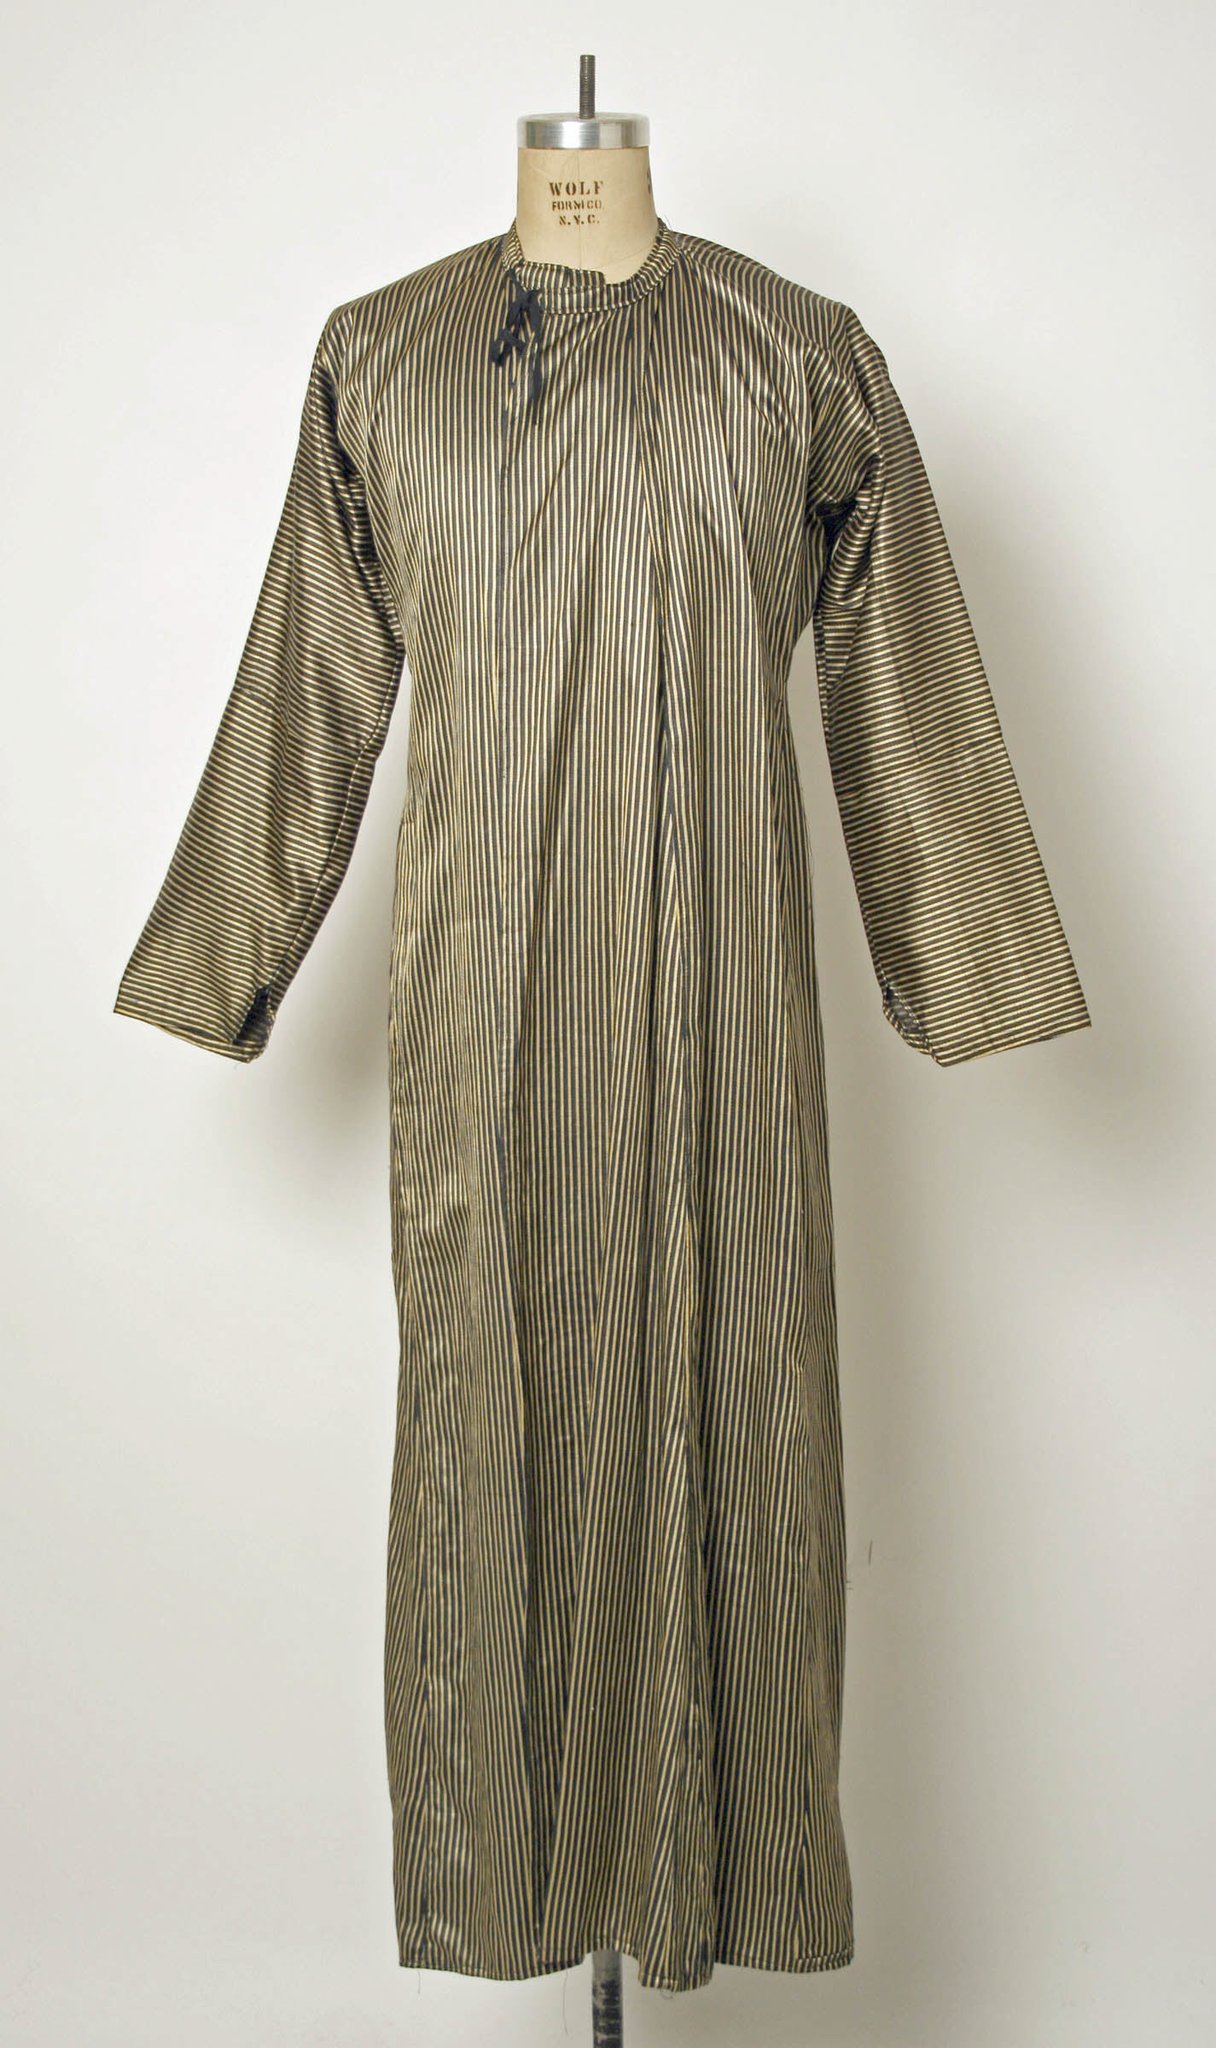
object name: kaftan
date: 1801-1900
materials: silk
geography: egypt or syria